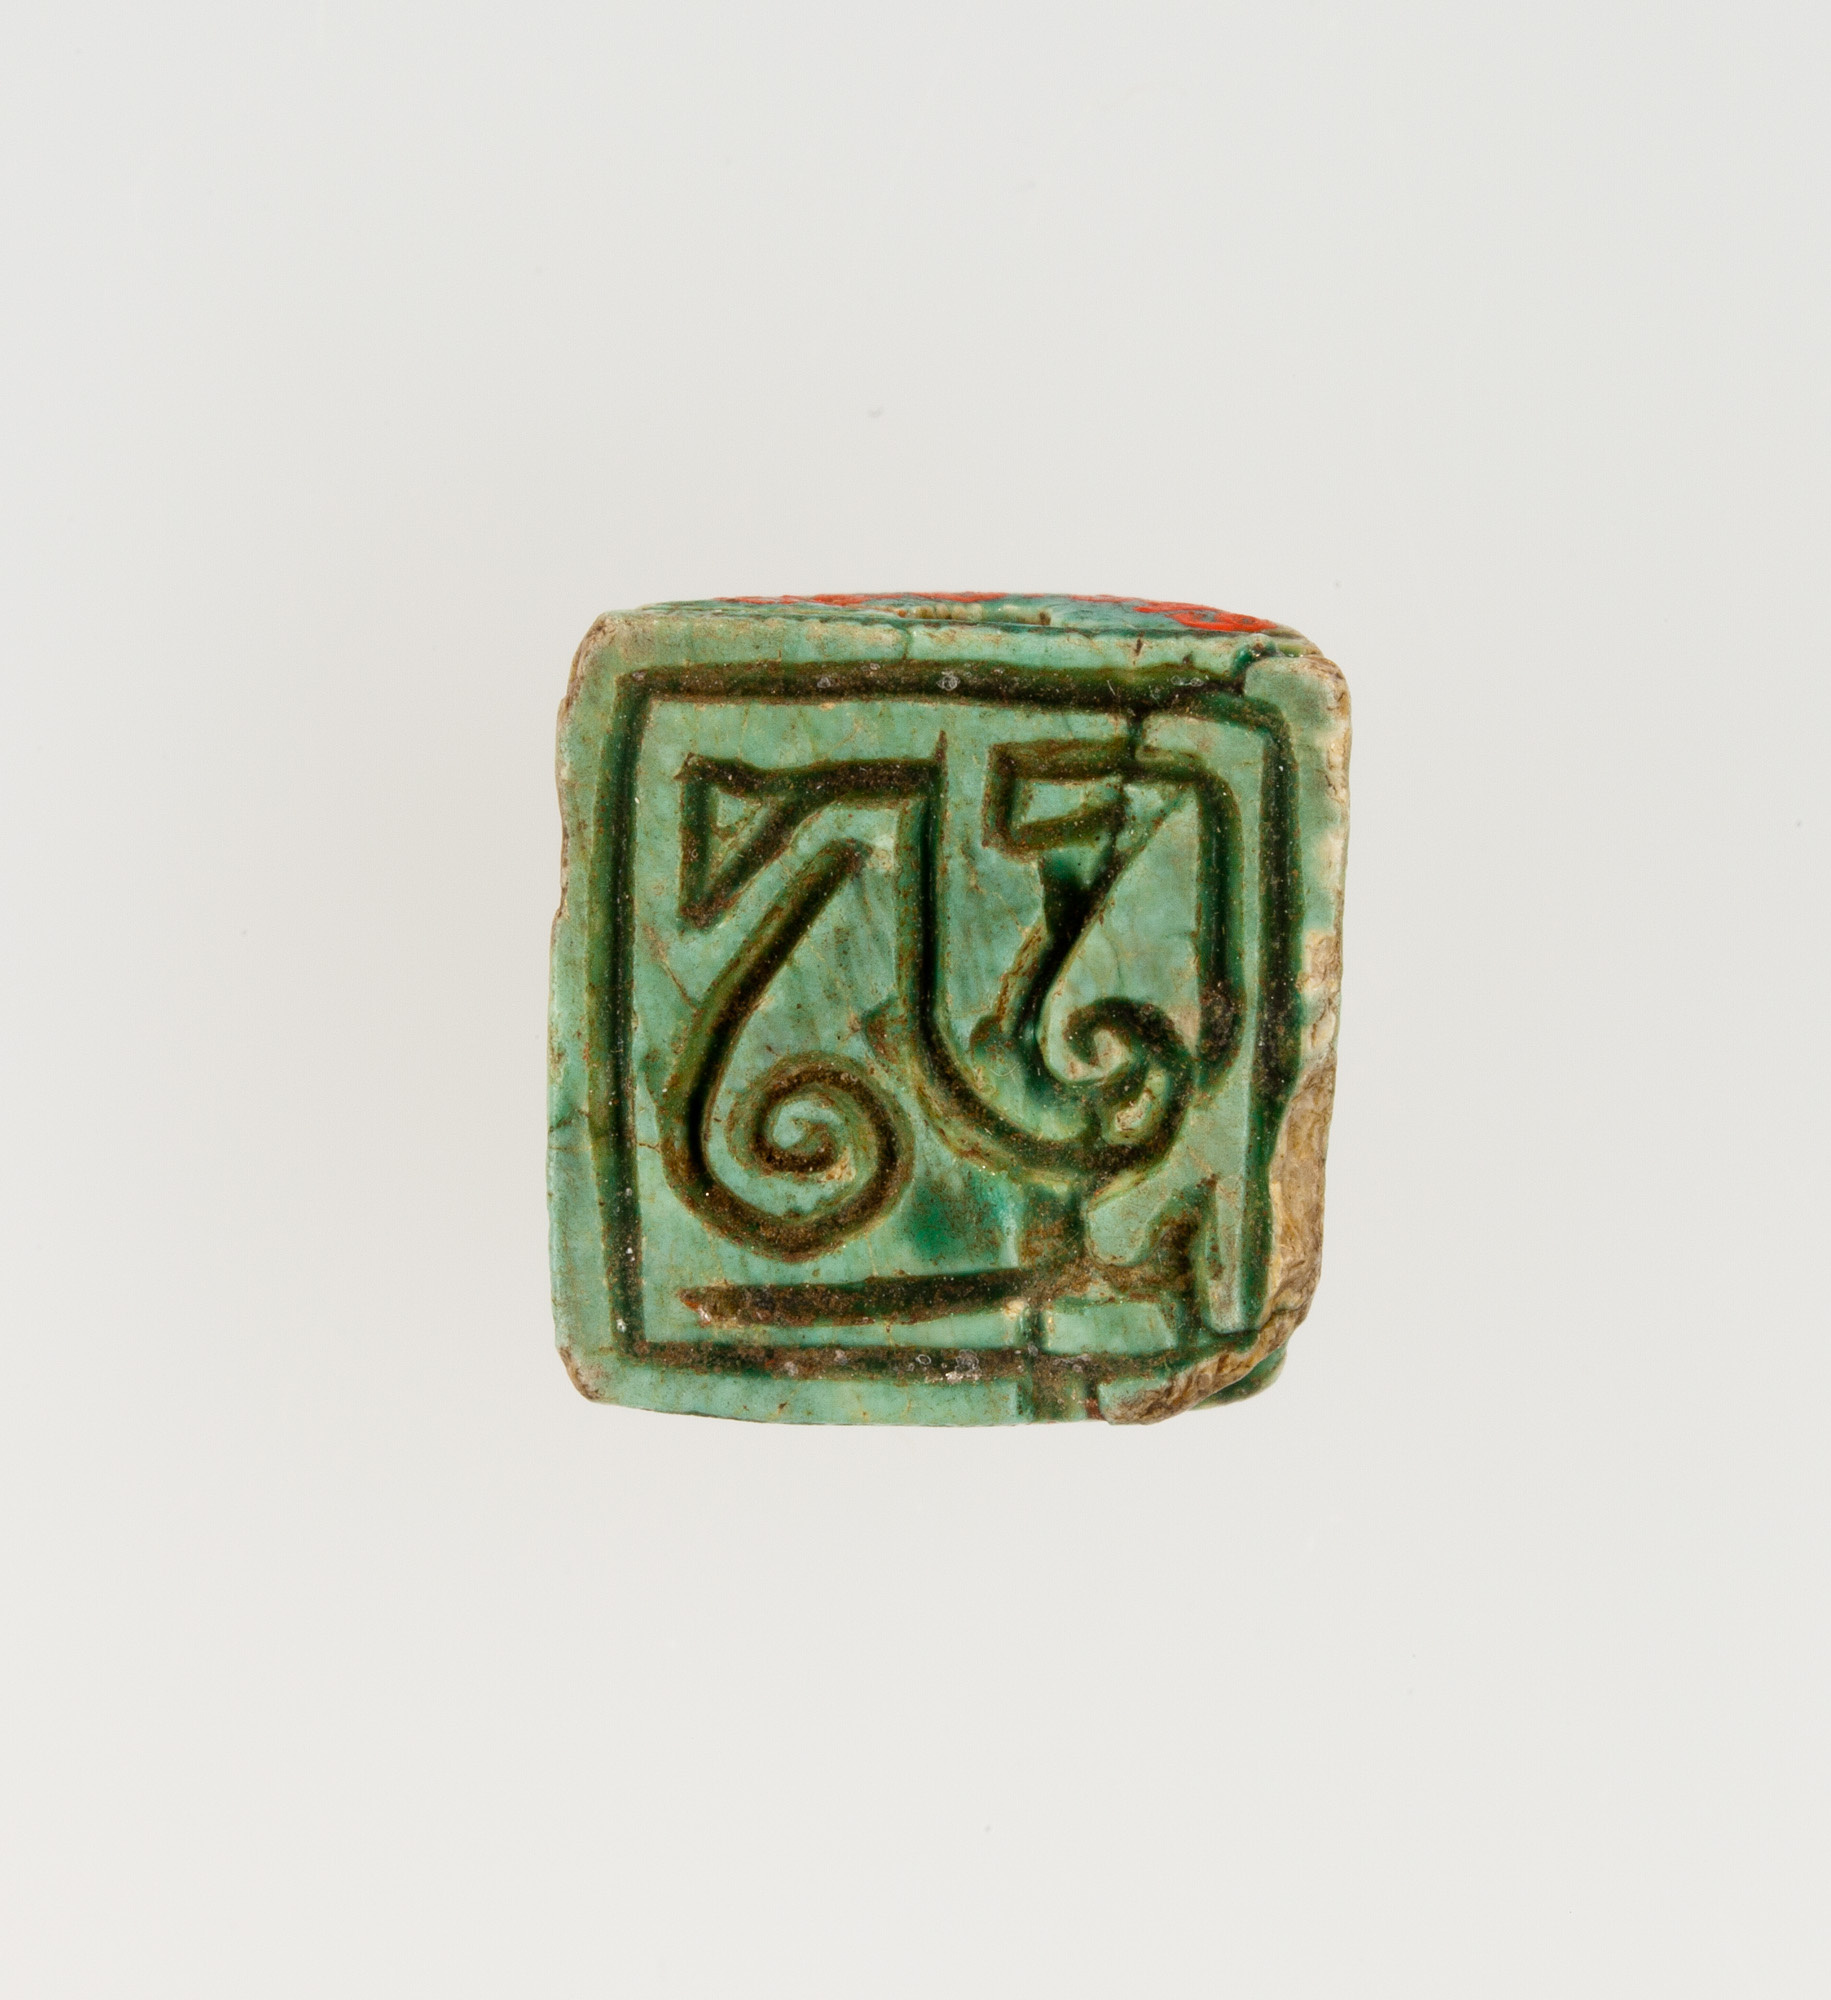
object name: stamp seal, amenhotep i, djeserkare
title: Half-Cylinder Stamp Seal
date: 1525-1504 BCE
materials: pottery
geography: egypt